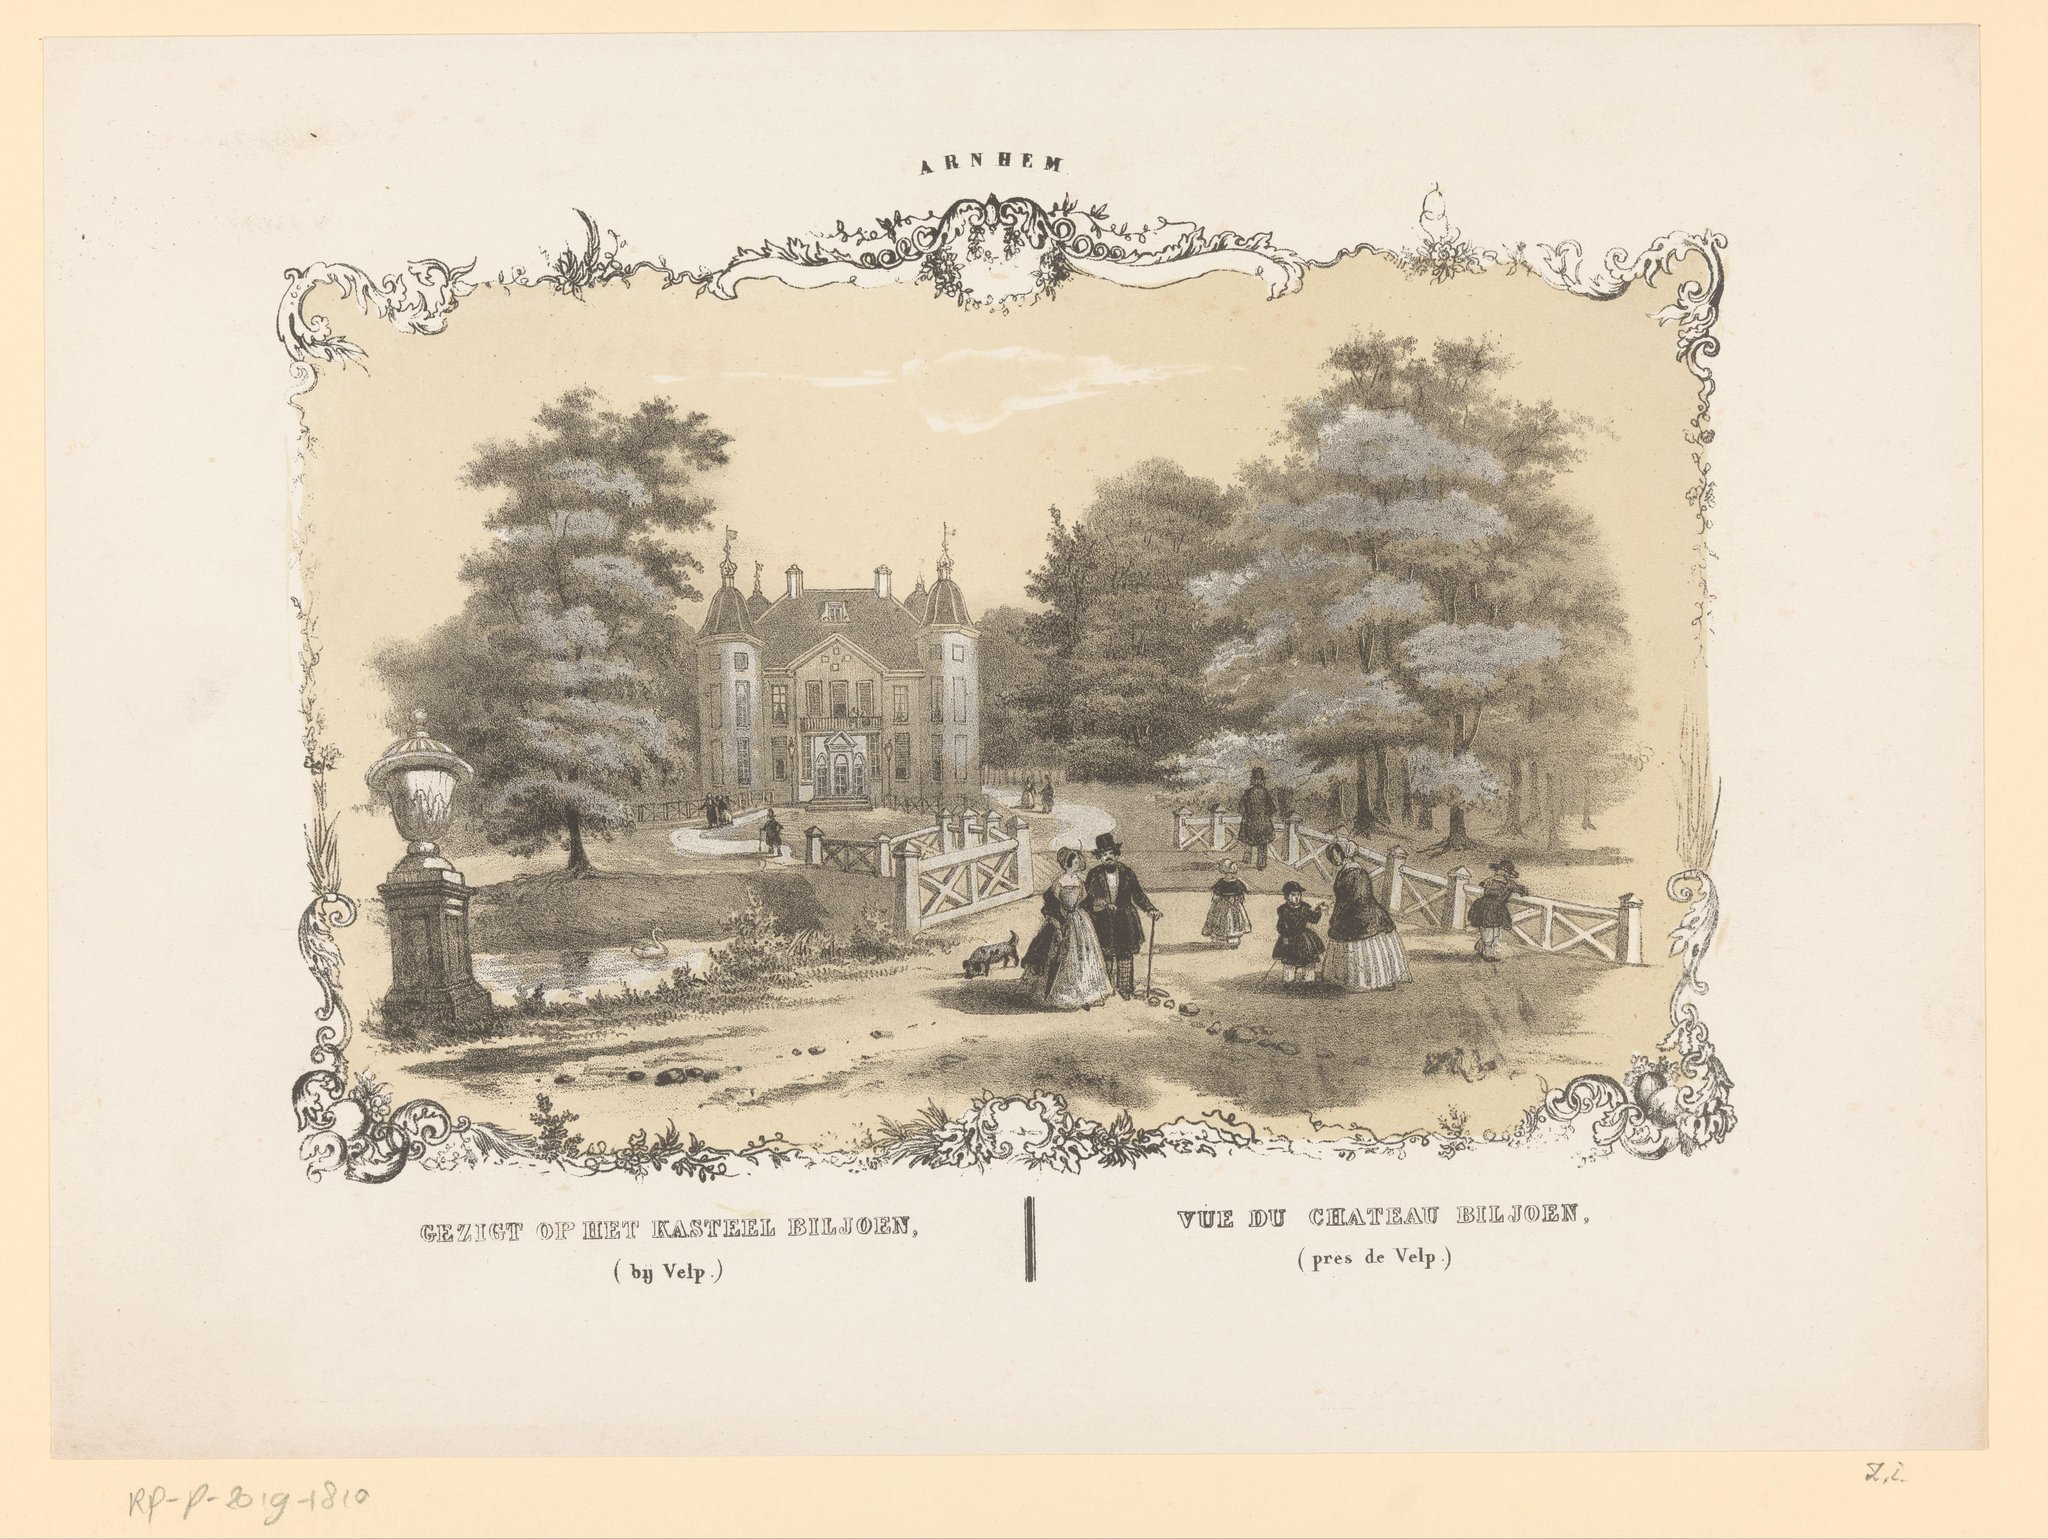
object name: print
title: Gezigt op het Kasteel Biljoen (bij Velp) / Vue du Chateau Biljoen (pres de Velp)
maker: hendrik wilhelmus last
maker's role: print maker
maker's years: 1817-1873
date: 1827-1873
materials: paper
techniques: tone lithography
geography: northern netherlands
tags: castle, landscape with tower or castle (+ city(-scape) with figures, staffage)